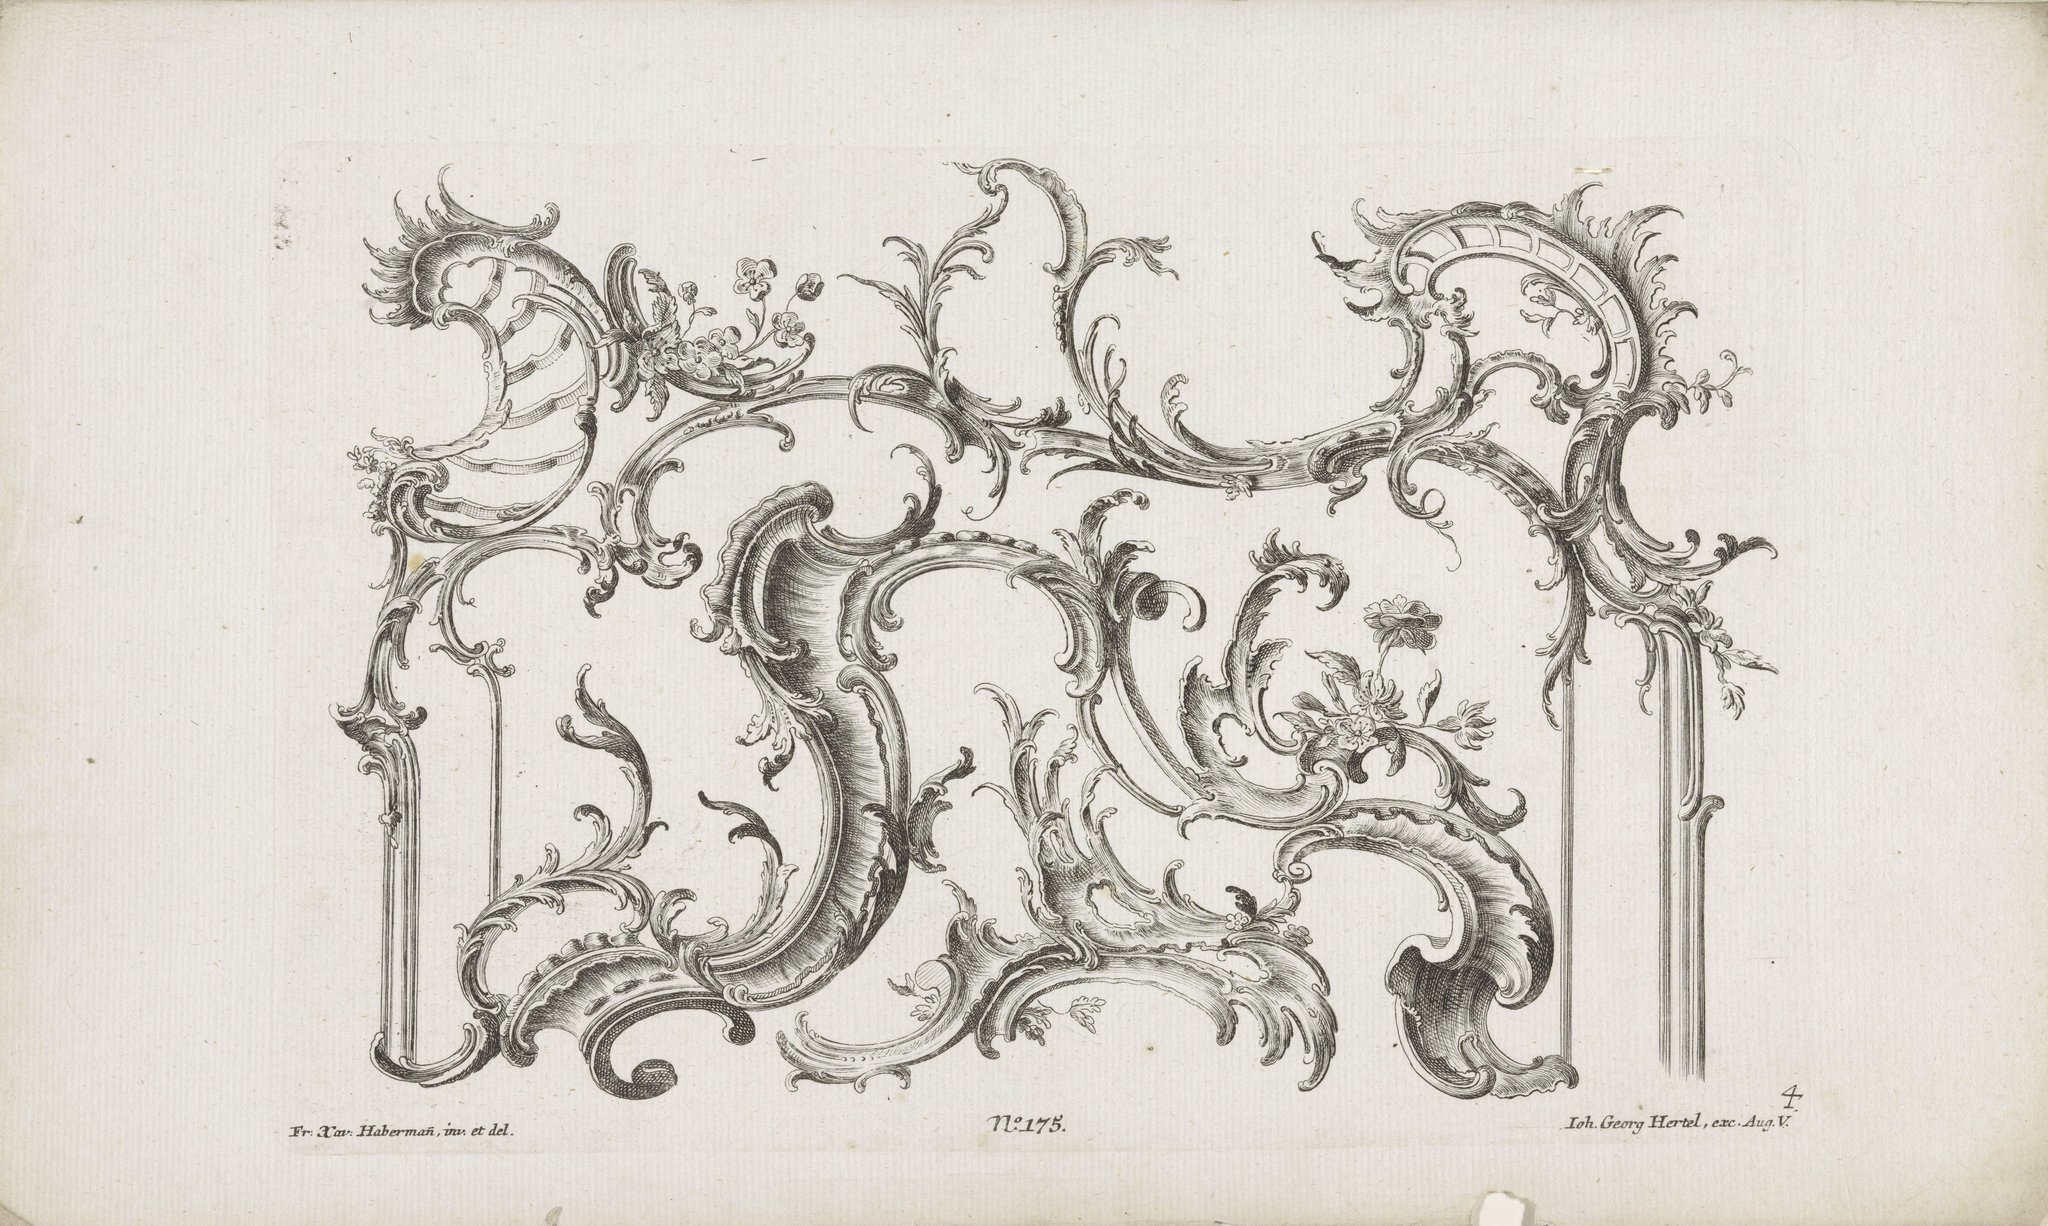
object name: ornament print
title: Omlijstingen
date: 1731-1775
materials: paper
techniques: etching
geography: augsburg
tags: rocaille ornament, ornaments ~ art (+ framing decorations)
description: Rocaille omlijstingen met bladmotieven. Uitgeversnummer 175.